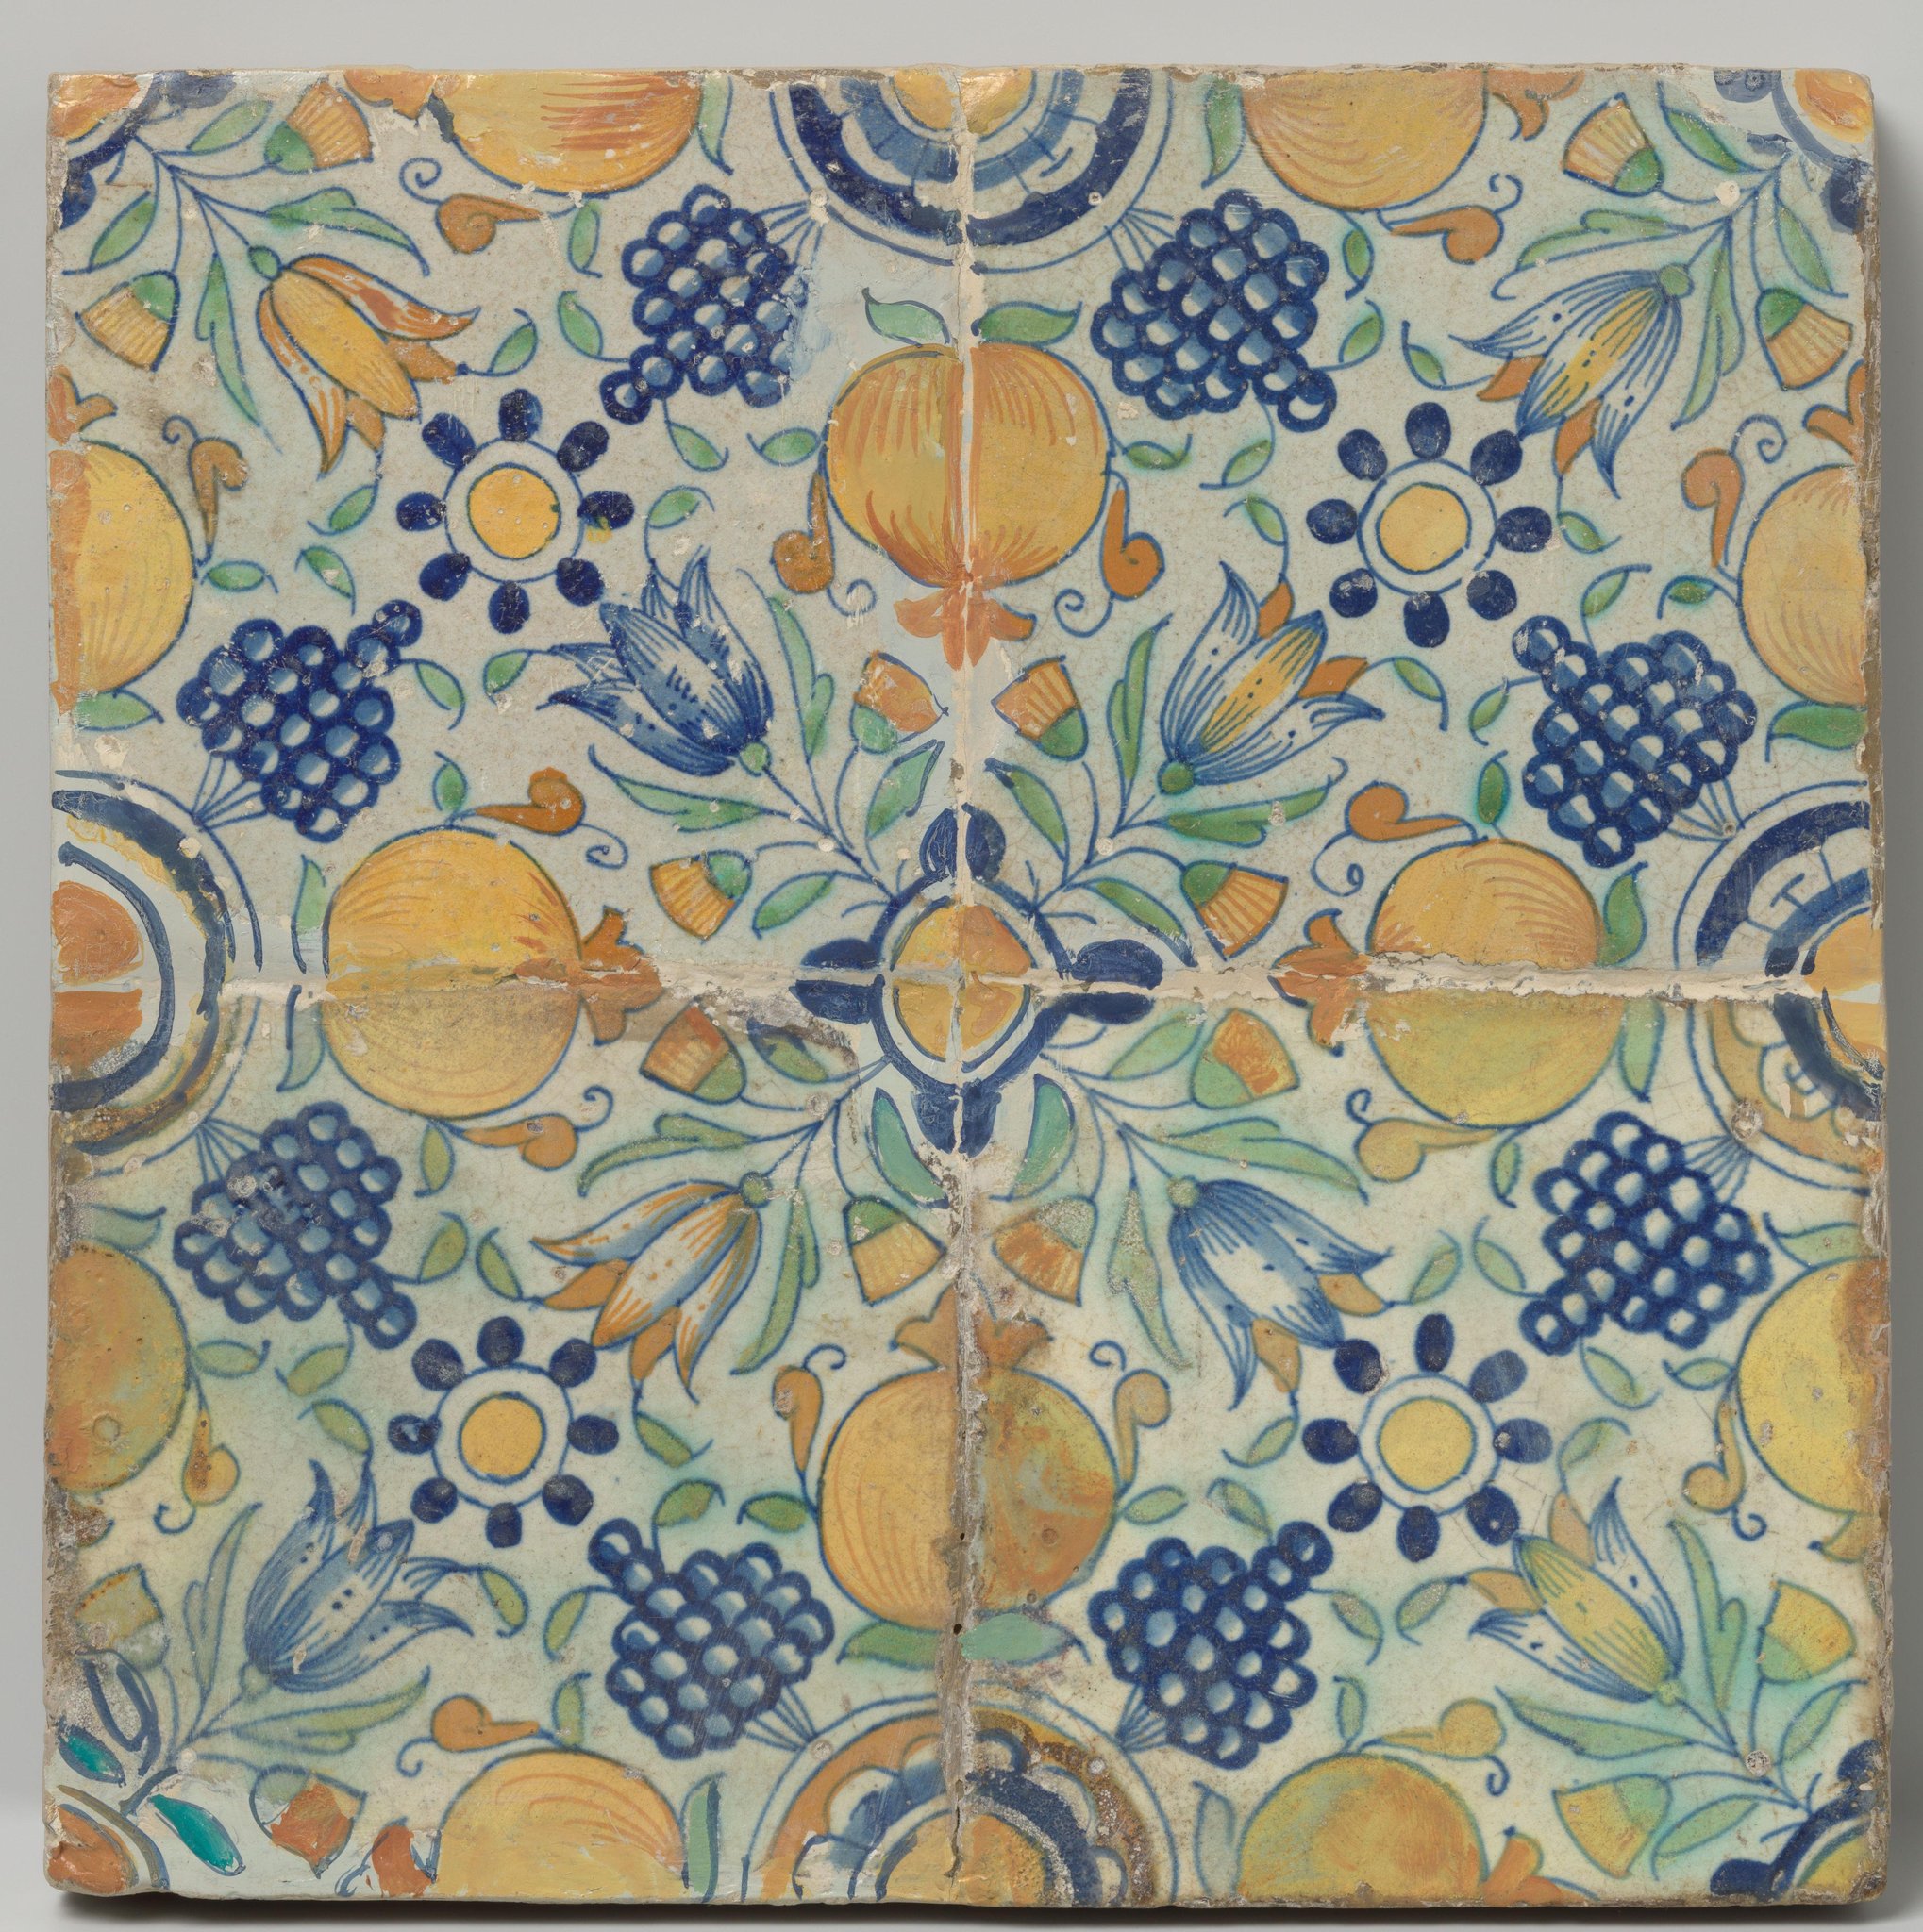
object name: tegelveld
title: Veld van vier tegels die samen één rozet vormen waaromheen tulpen, granaatappels en druiventrossen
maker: Anonymous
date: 1600-1625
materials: earthenware, glaze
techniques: maiolica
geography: netherlands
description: Veld van vier tegels (2 x 2) elk met een veelkleurig (blauw, groen, geel en oranje) geschilderde voorstelling. Samen vormen zij een rozet omgeven door tulpen, granaatappels en druiventrossen. In de hoeken, een bloemdekor.